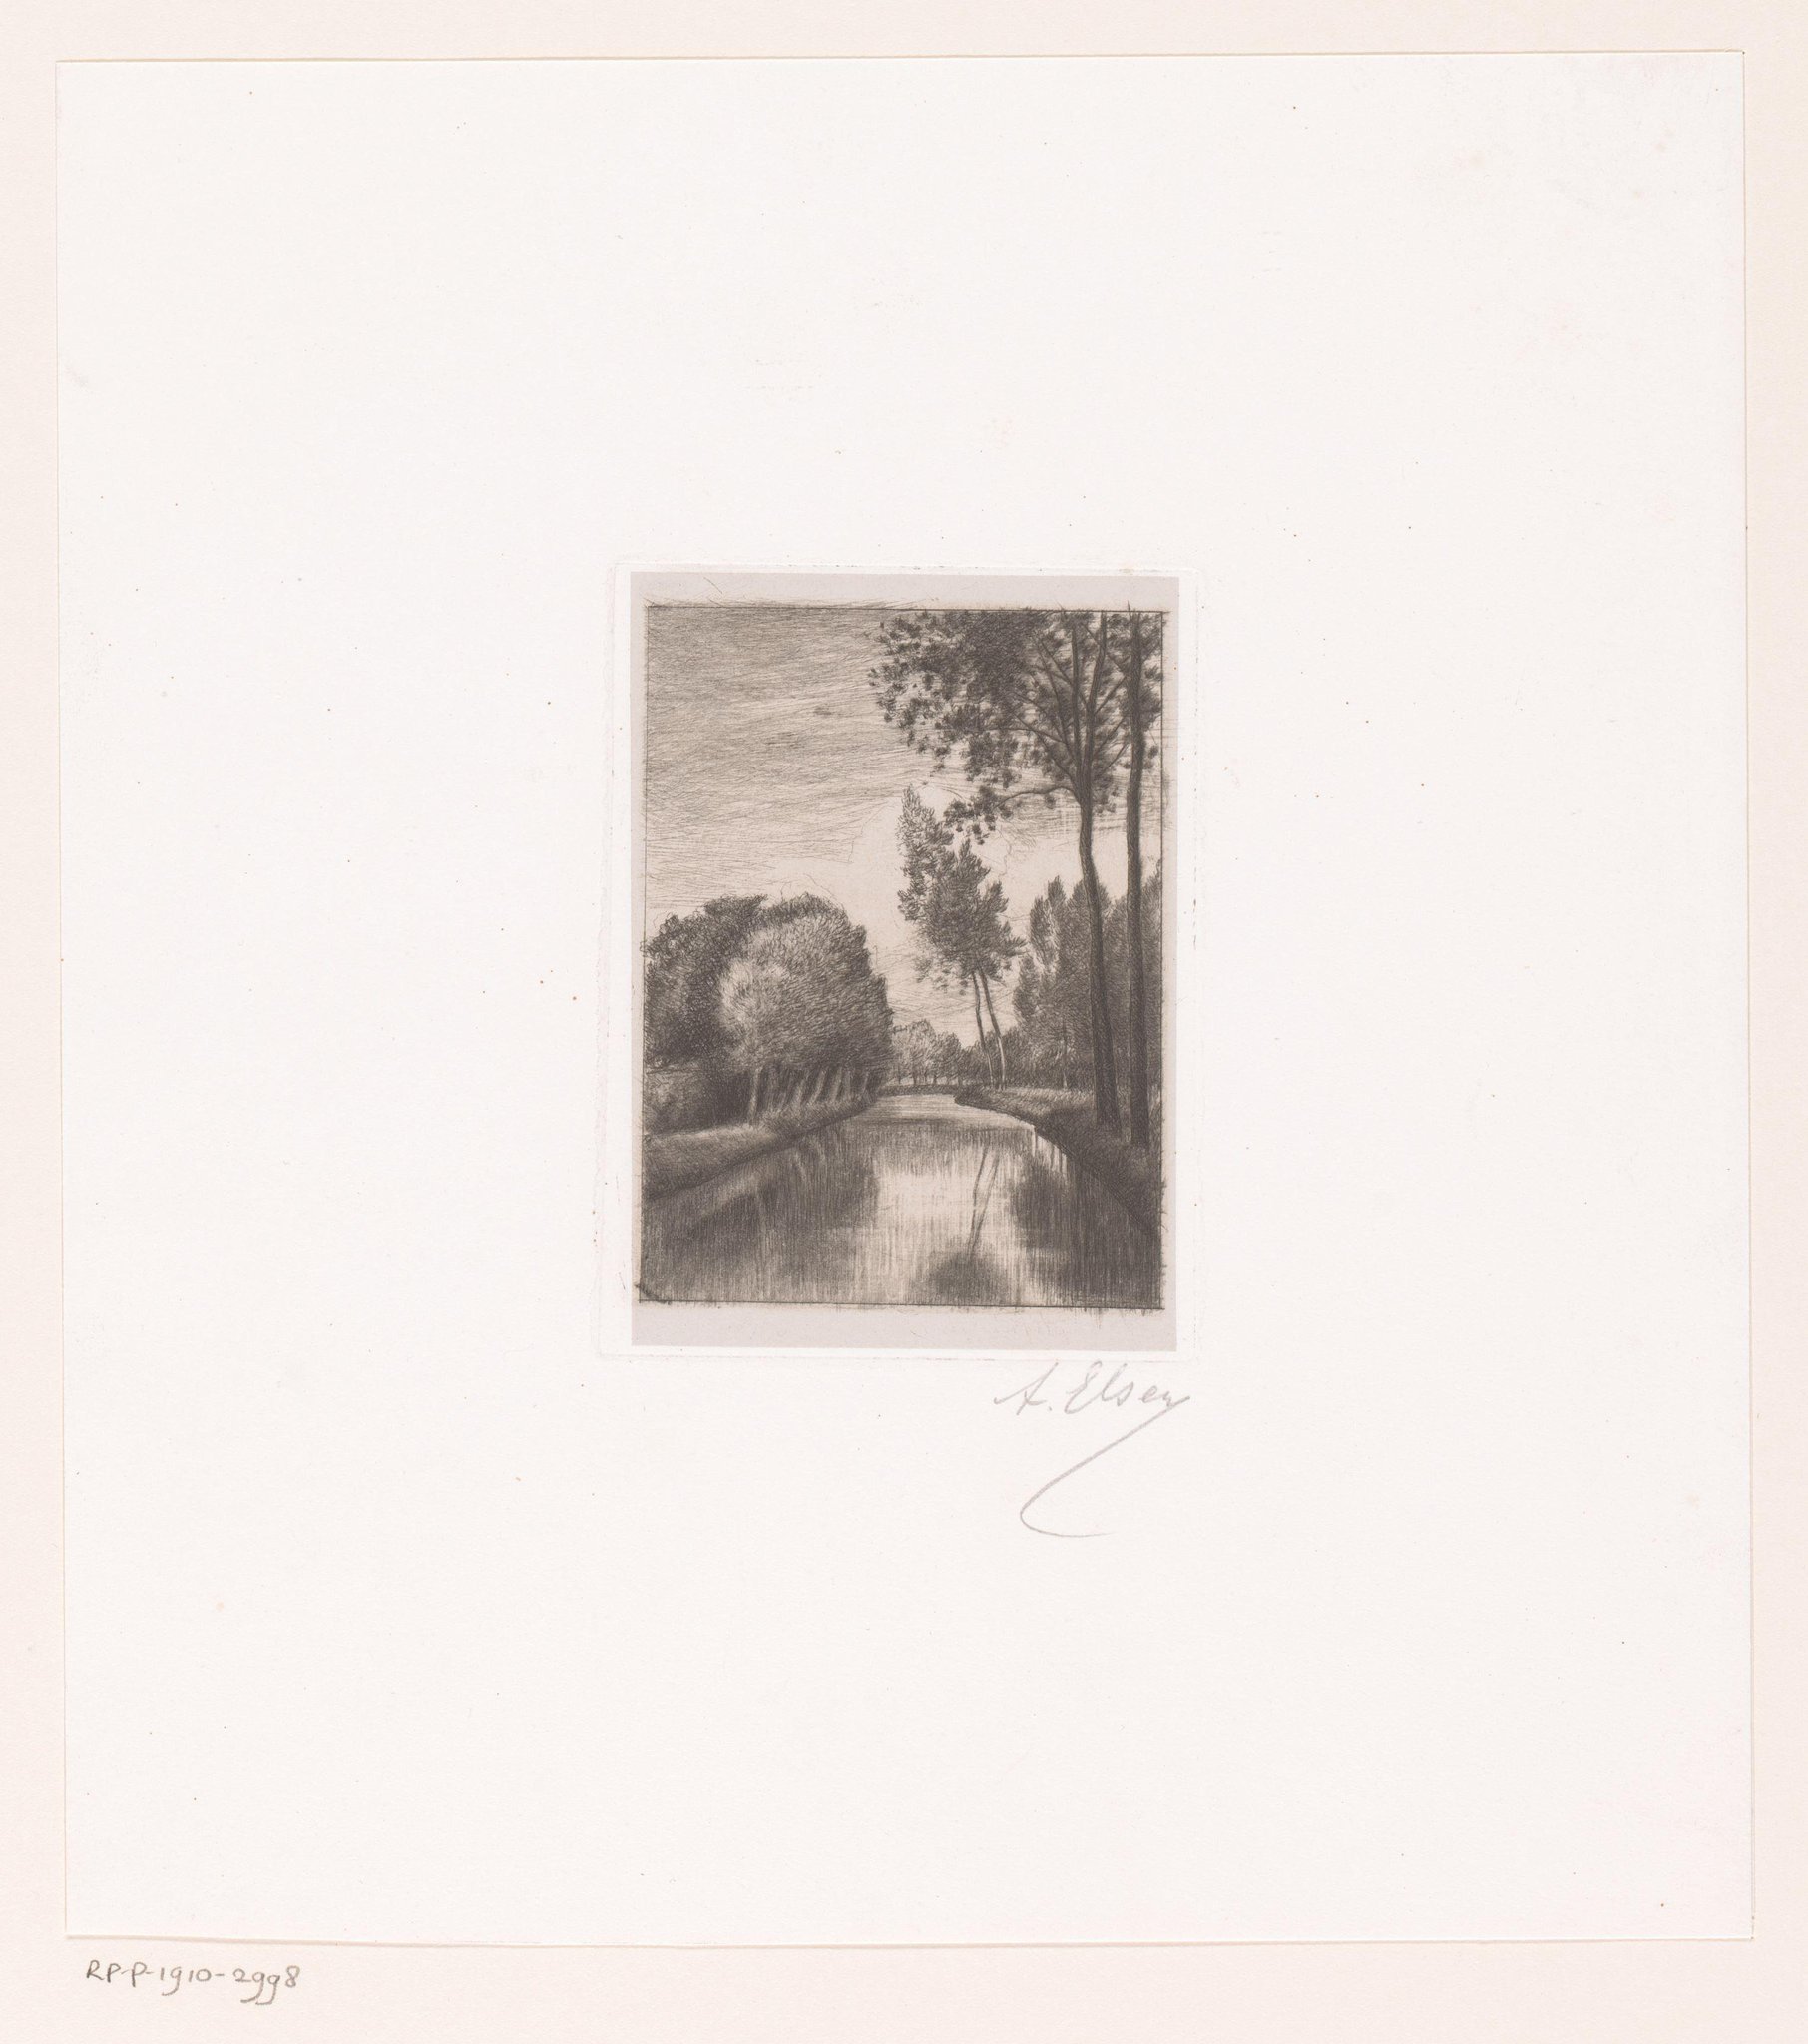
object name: print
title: Kanaal met begroeiing langs de oevers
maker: alfred elsen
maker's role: painter, print maker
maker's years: 1850-1914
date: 1860-1910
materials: paper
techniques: etching, intaglio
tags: canal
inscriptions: collector's mark: Lugt 2228